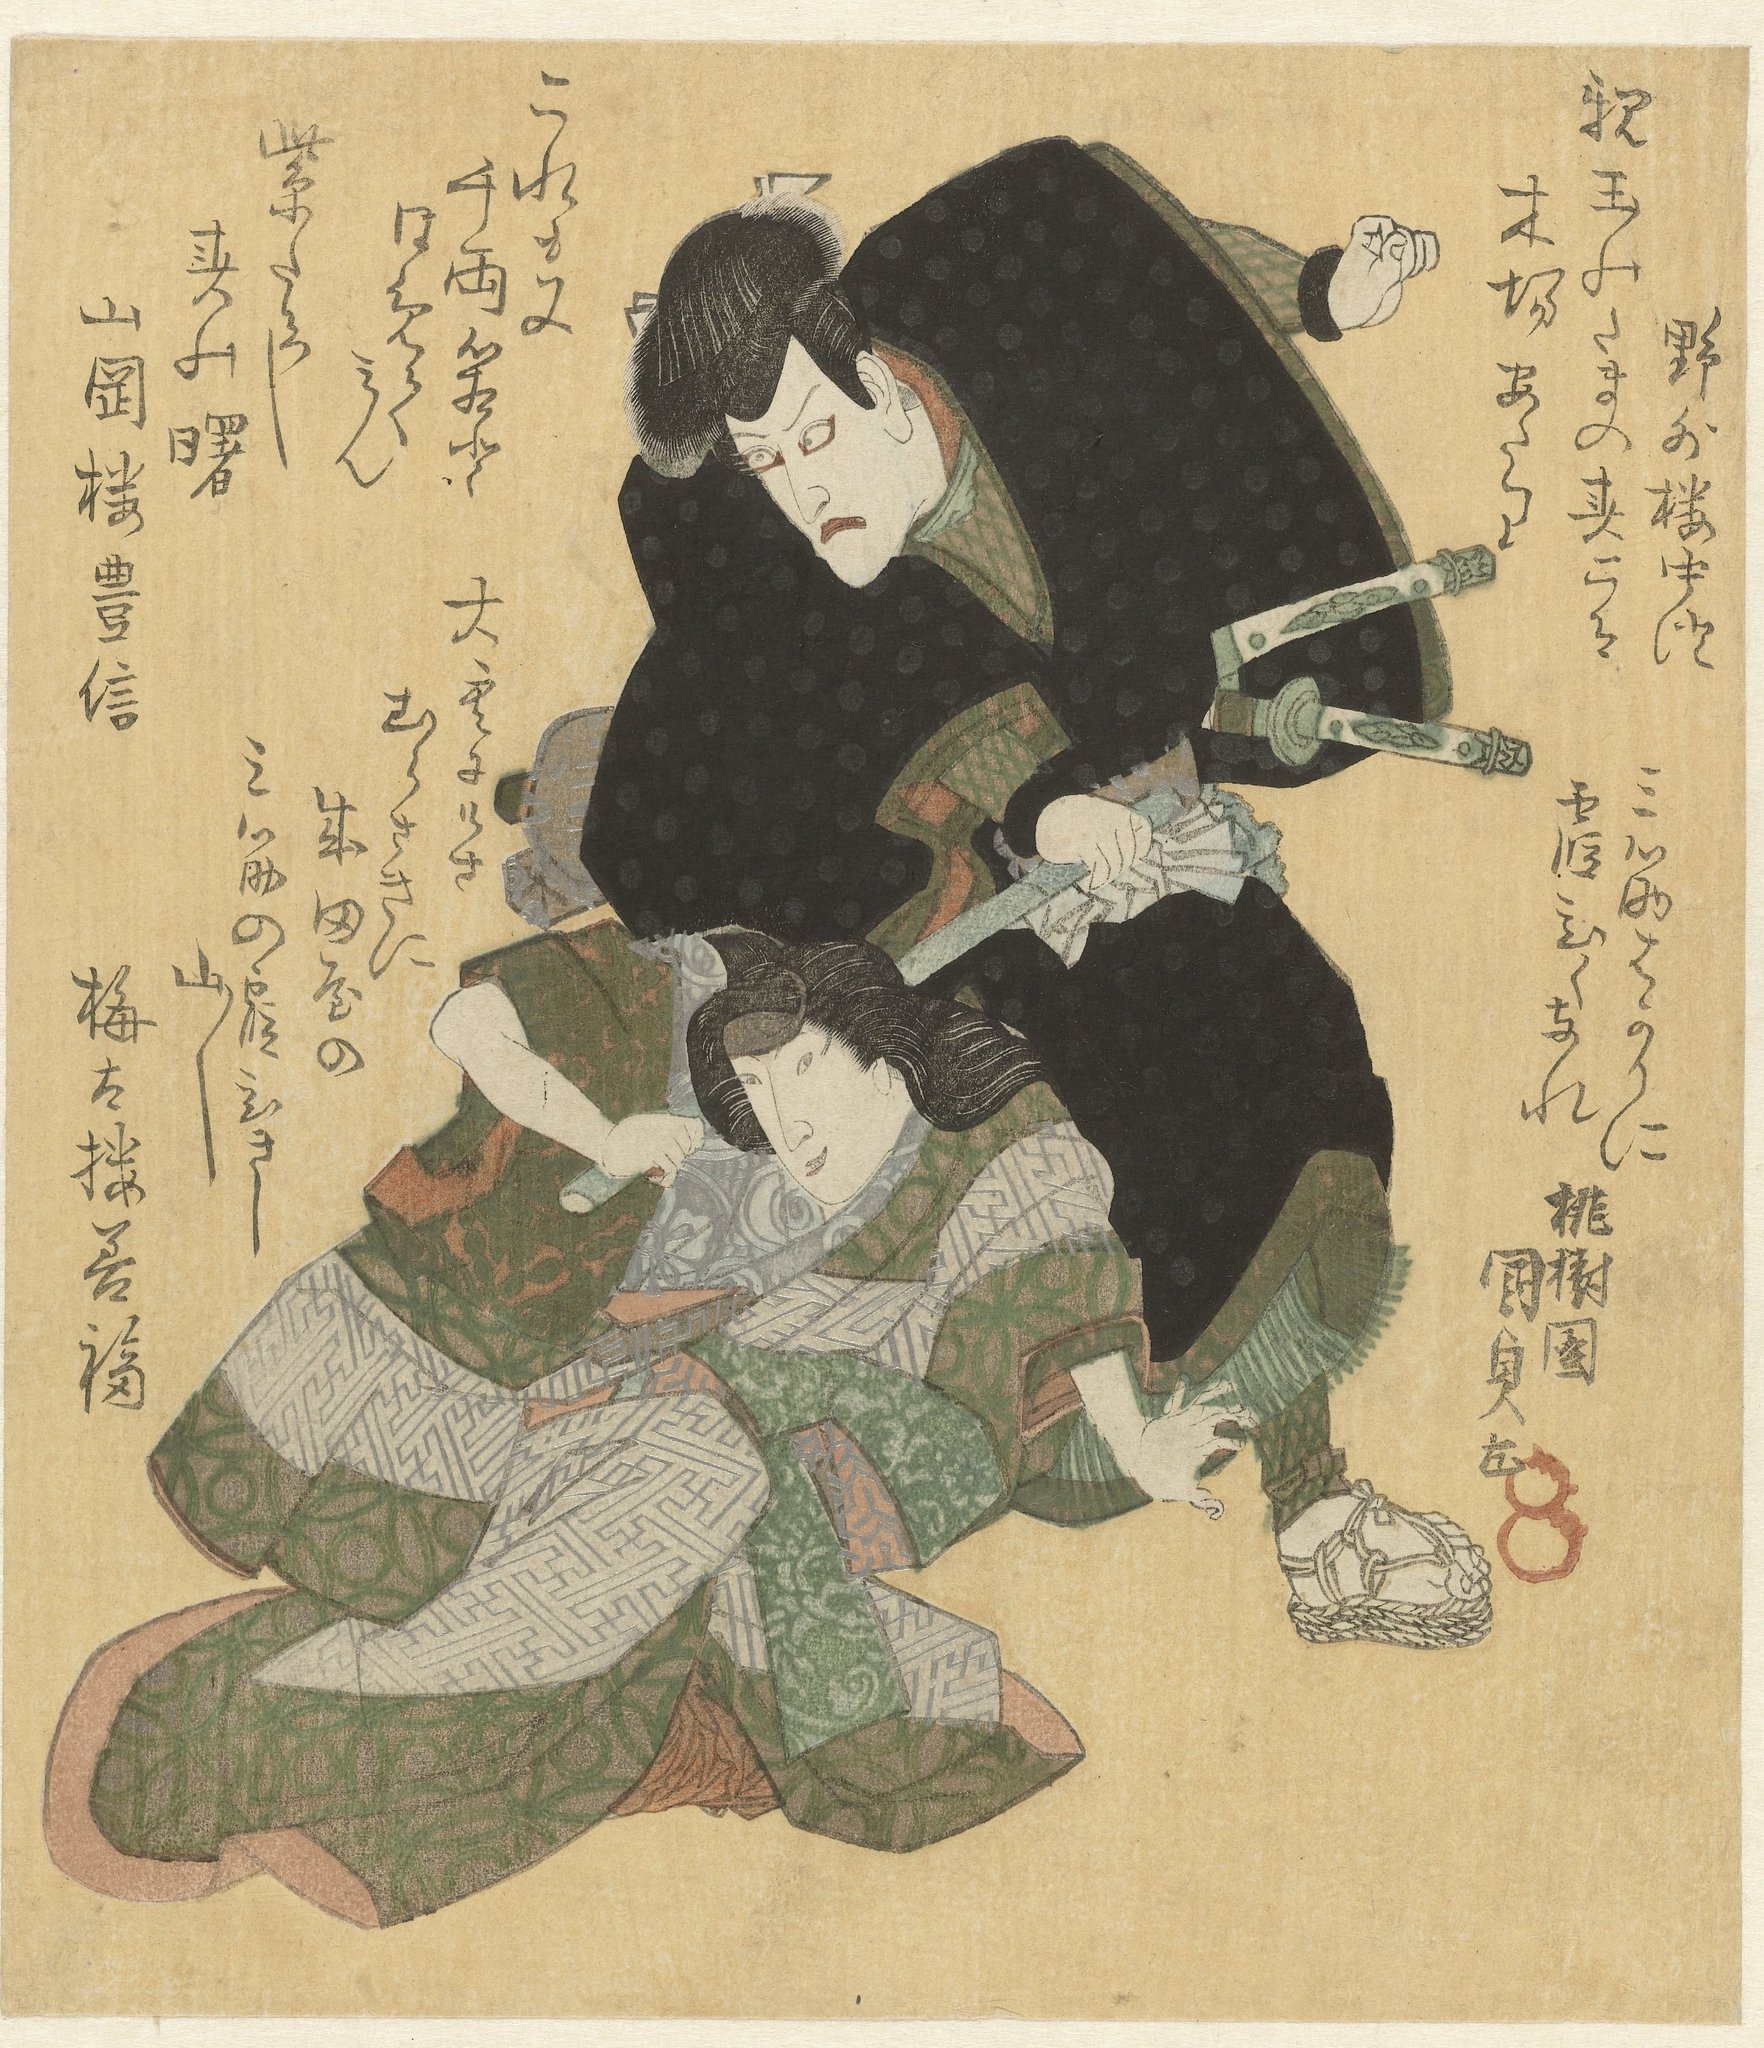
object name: print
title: A Man en Woman Fighting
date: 1831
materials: paper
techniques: woodcut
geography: japan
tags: actor (on the stage)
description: Een man in zwarte kleding grijpt de stok waarmee een vrouw hem sloeg. De man is Ishikawa Goemon, gespeeld door acteur Ichikawa Danjûrô VII (1791-1859). De vrouw, acteur Iwai Shijaku (1804-1845), speelt de rol van een courtisane genaamd Segawa, die eigenlijk Oritsu heet en de vrouw van Ishikawa Goemon is. Deze scene komt uit het toneelstuk Masago no gohiiki, opgevoerd in het Kawarazaki theater in 1830. Met drie gedichten.